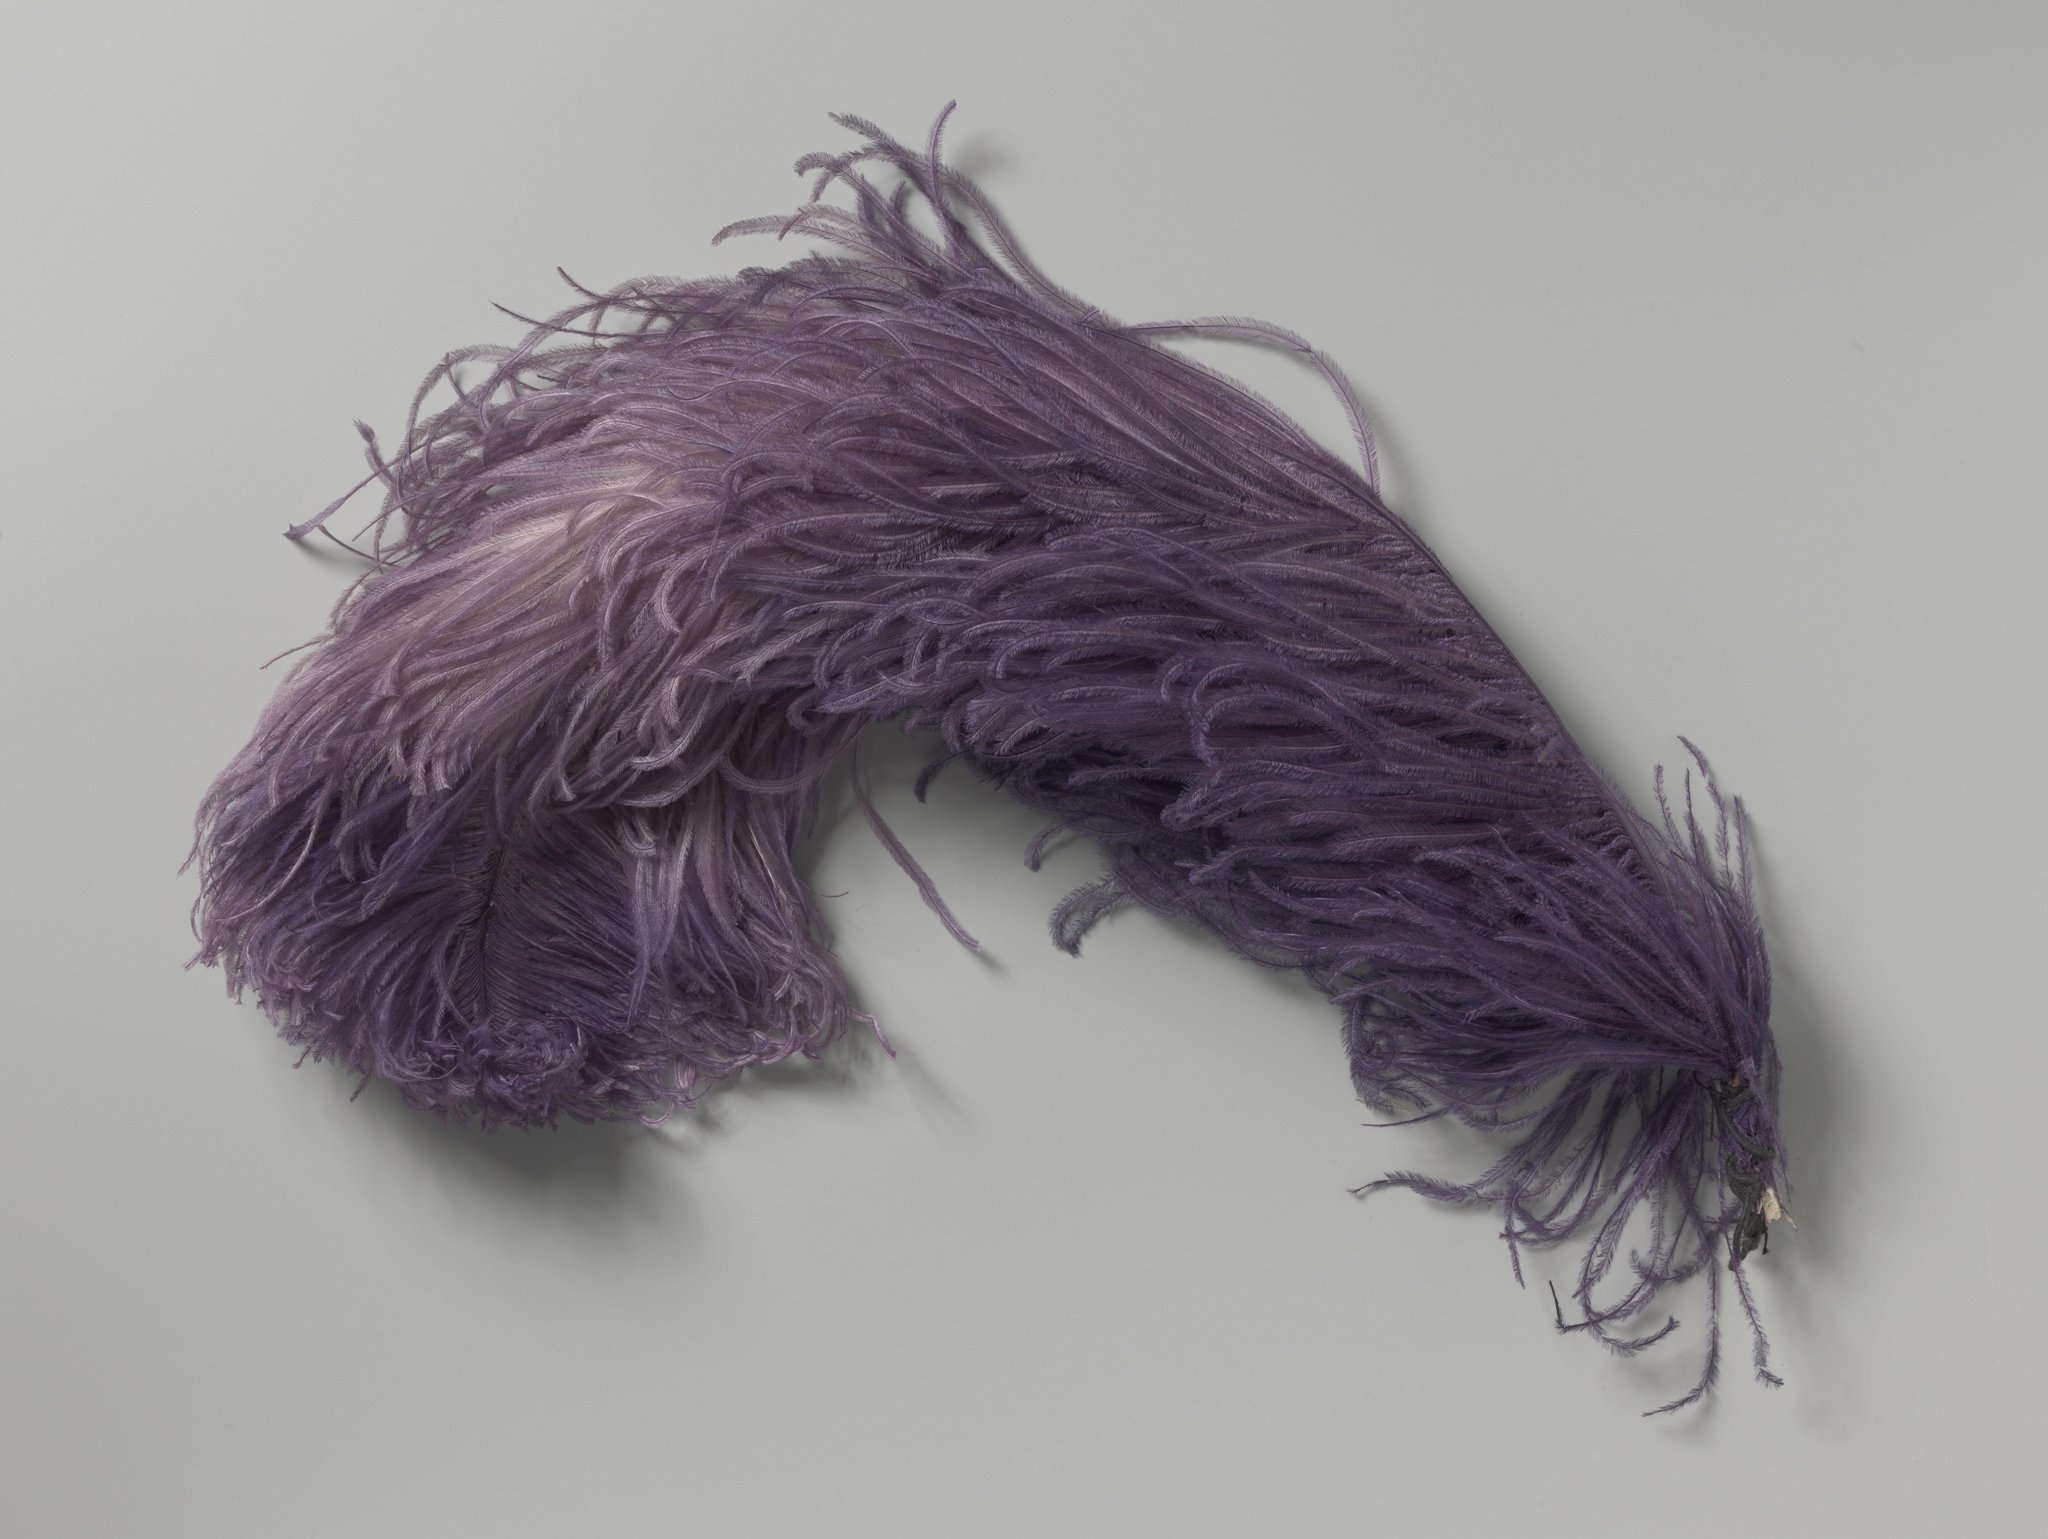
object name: womenswear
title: Struisveer, lila van kleur, met verloop van donker naar licht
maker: Anonymous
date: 1895-1915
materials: metal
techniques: painting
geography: western europe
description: Struisveer, lila van kleur, met verloop van donker naar licht.